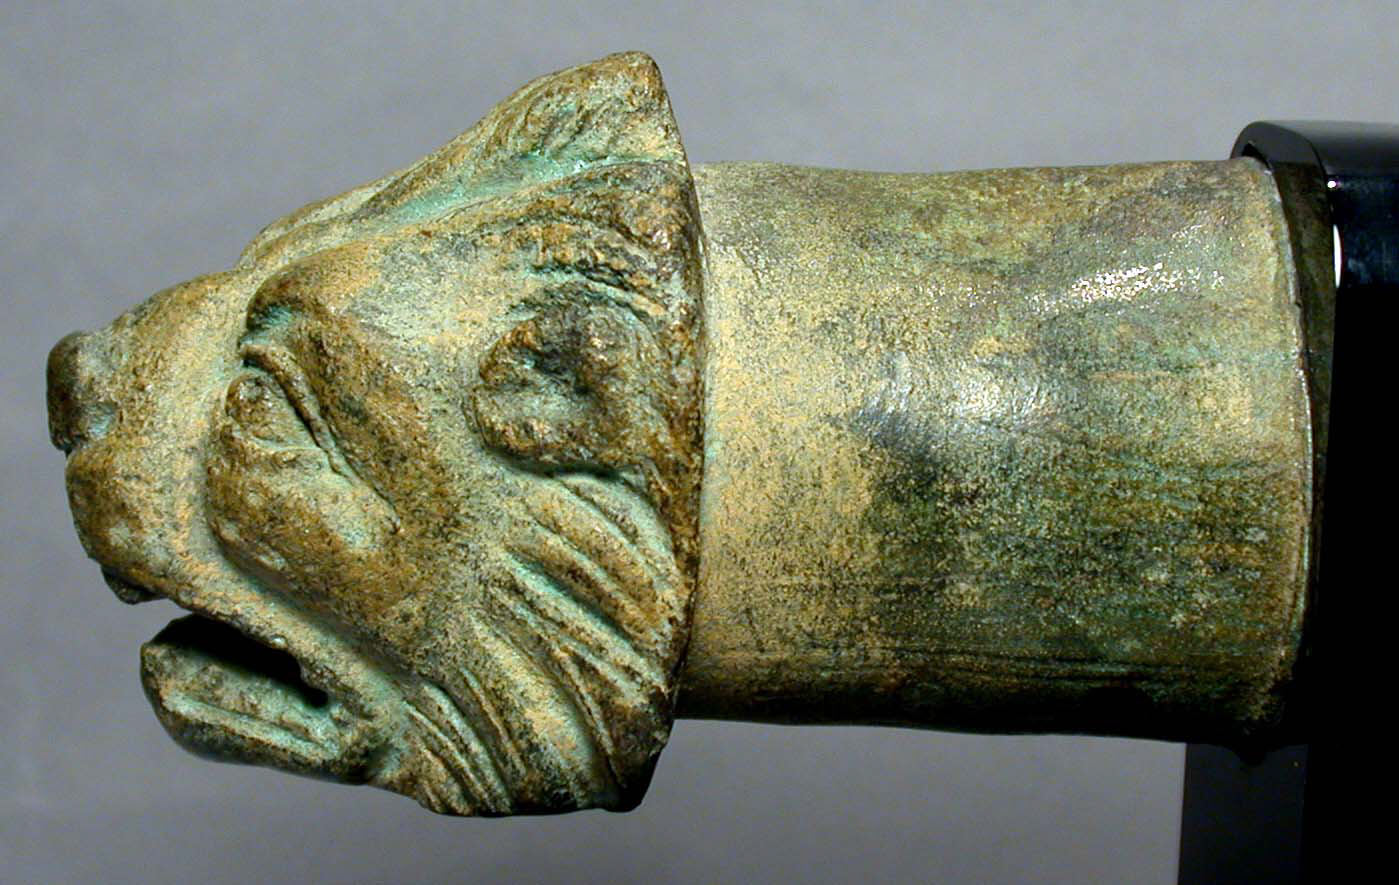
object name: attachment with head of a lion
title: Bronze attachment with head of a lion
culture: roman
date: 1-200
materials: bronze